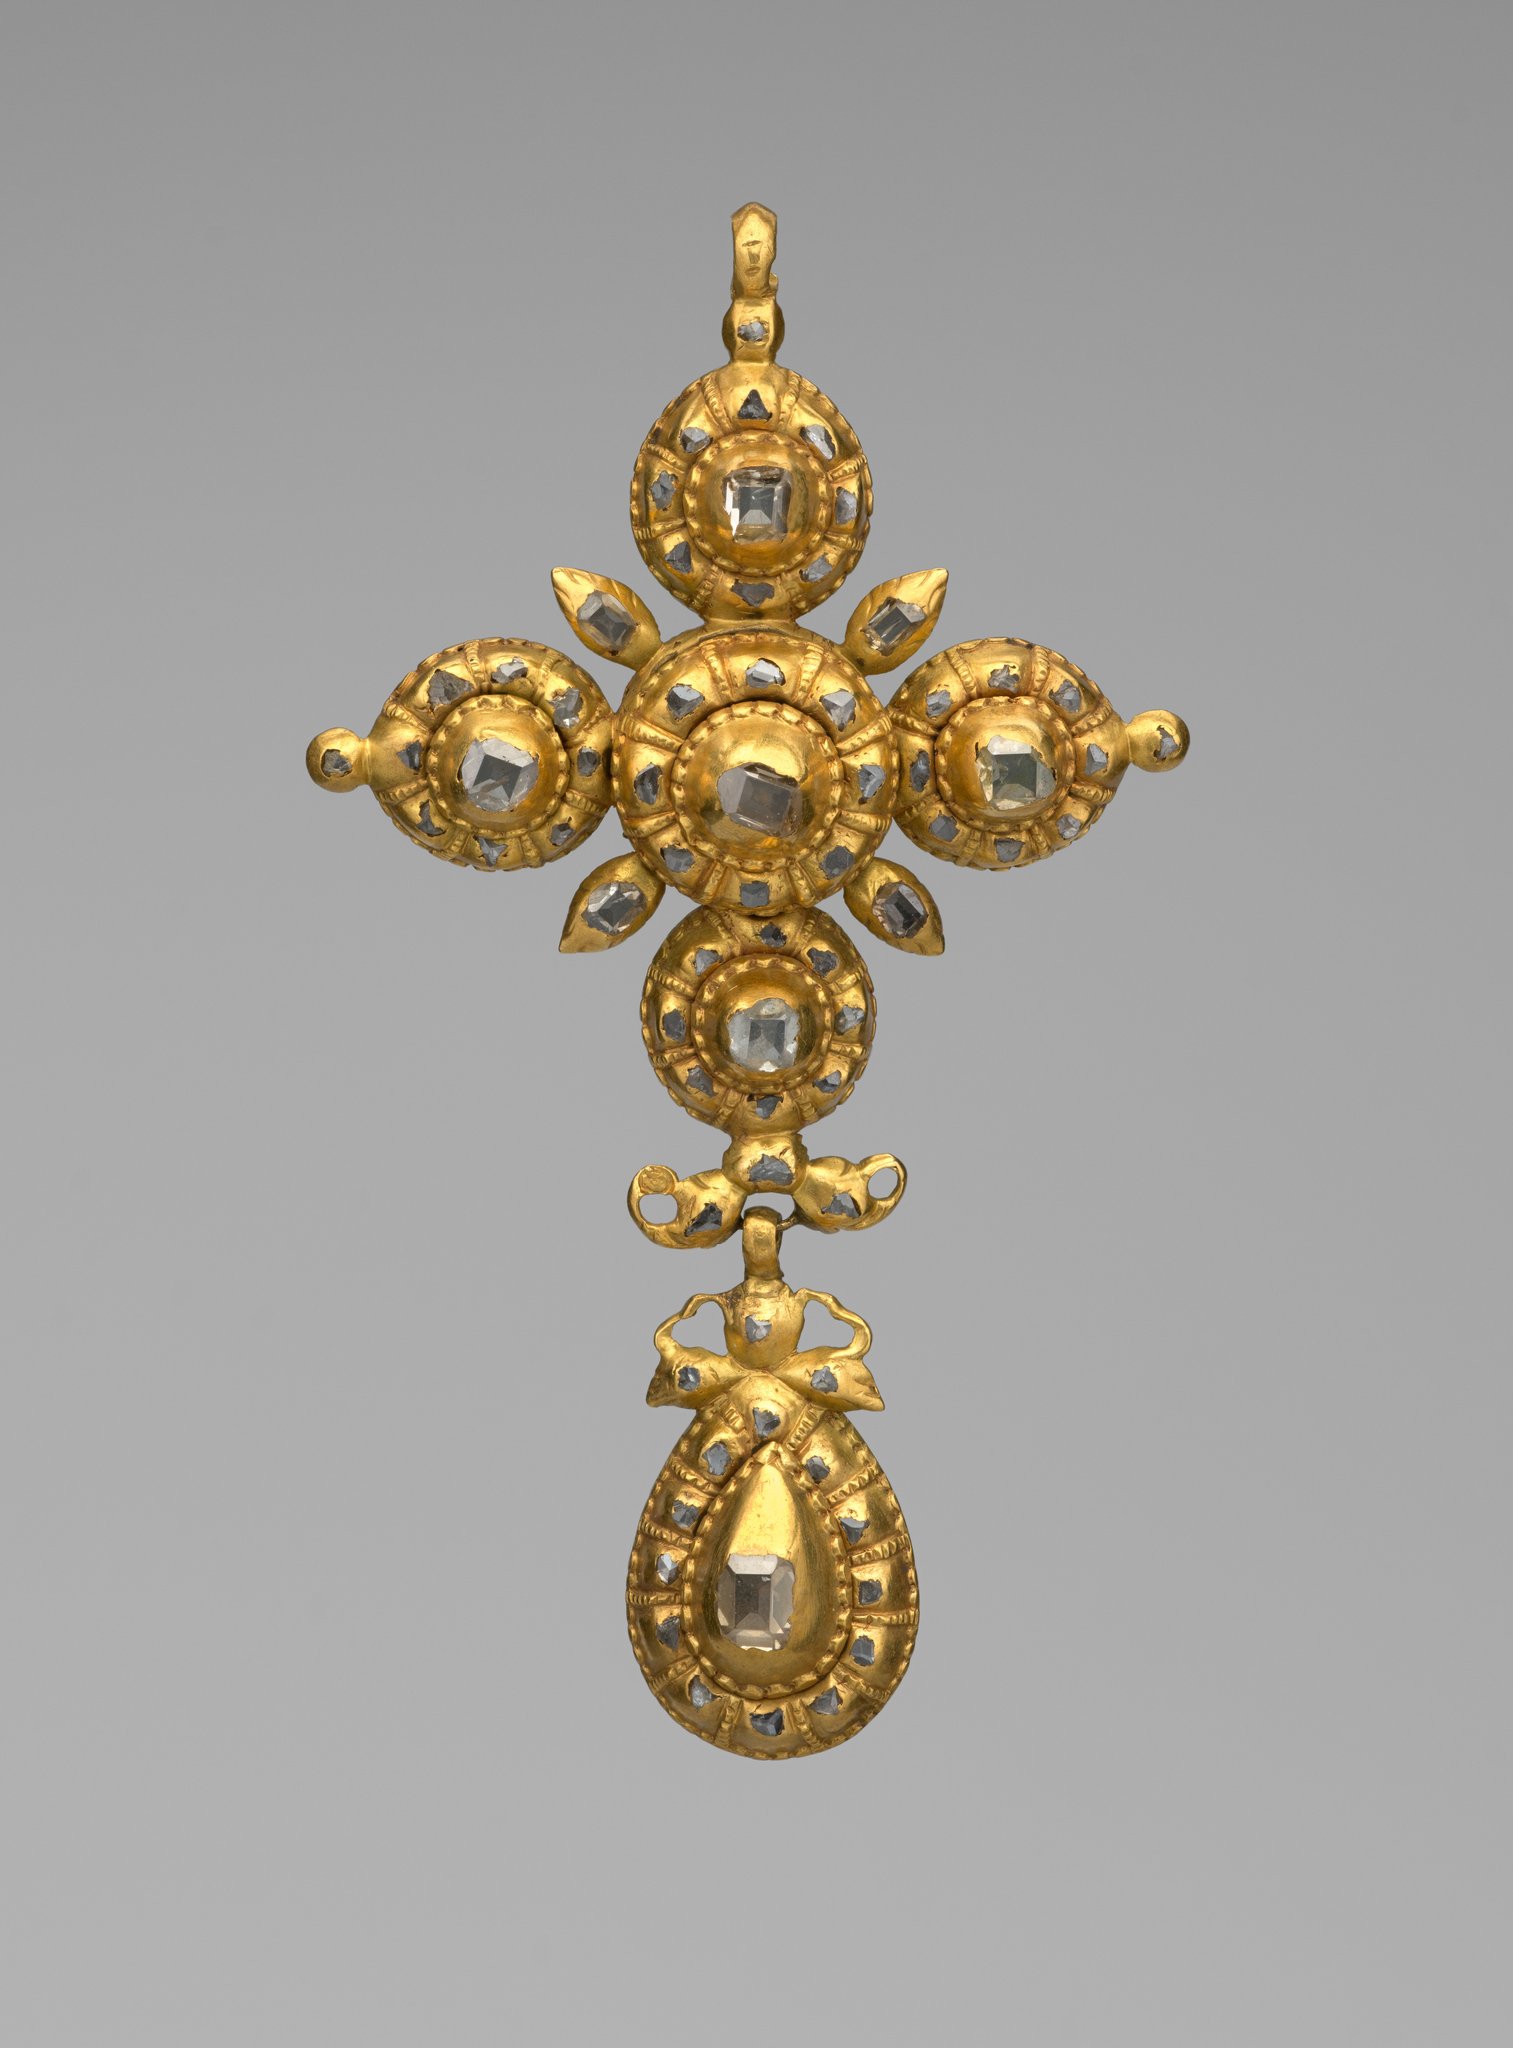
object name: cross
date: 1701-1800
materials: gold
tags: cross